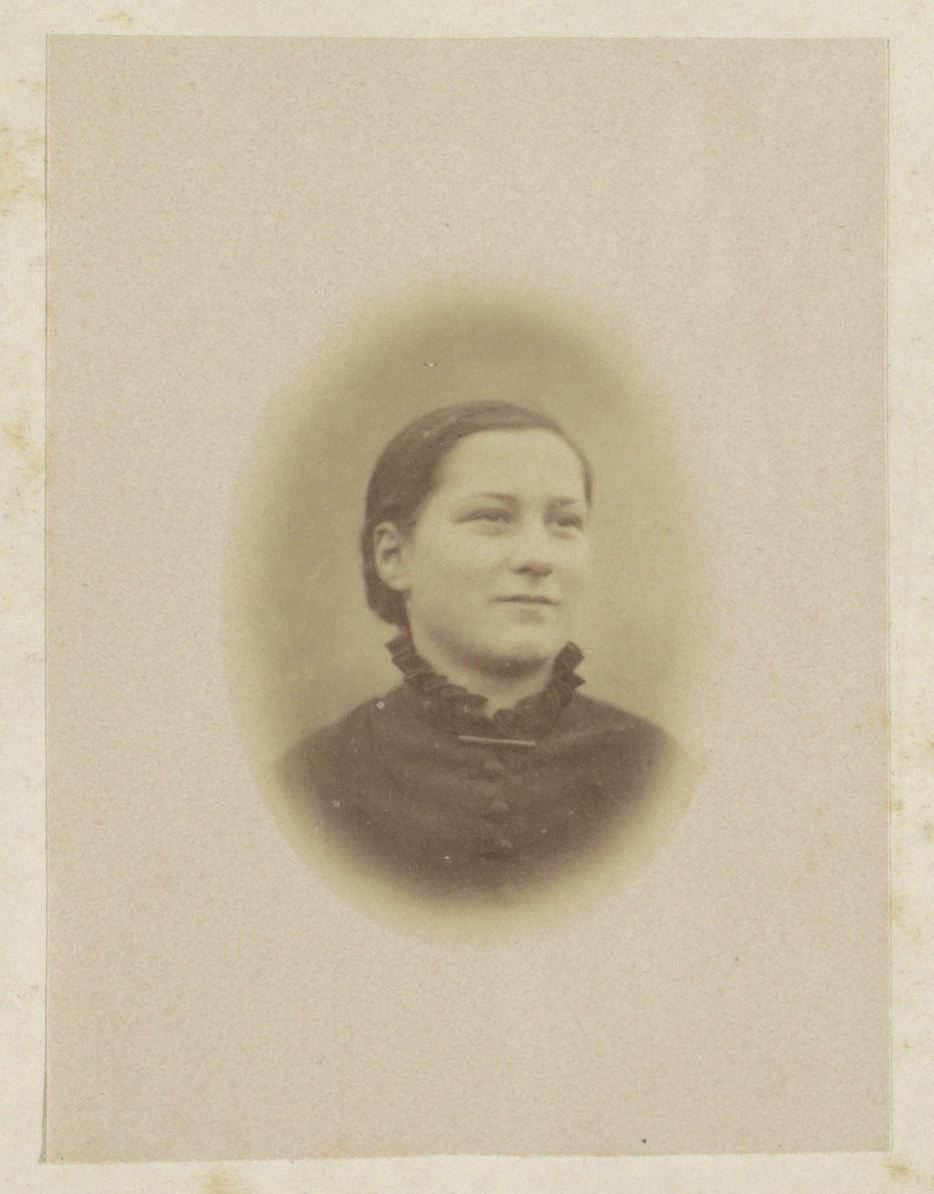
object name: photograph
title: Portret van een onbekende Française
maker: Anonymous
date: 1883-1886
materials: photographic support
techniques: albumen print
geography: france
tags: adult woman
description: Onderdeel van Album van een Franse amateurfotograaf met opnames van familie, militairen, industrie, landschappen en bezienswaardigheden in Frankrijk.